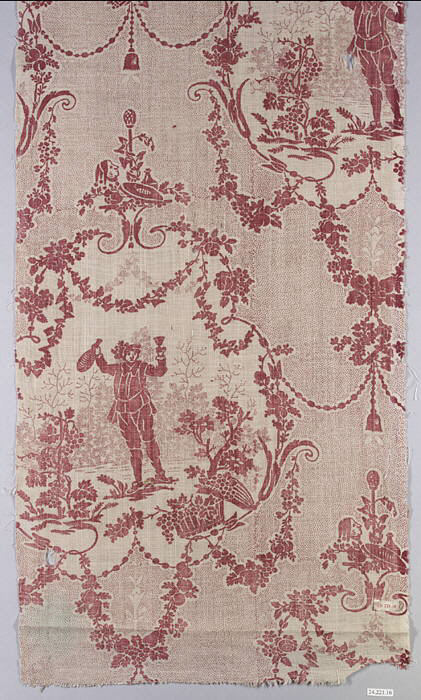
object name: piece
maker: oberkampf manufactory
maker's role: manufactory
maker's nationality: french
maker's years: 1760-1843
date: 1770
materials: linen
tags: men